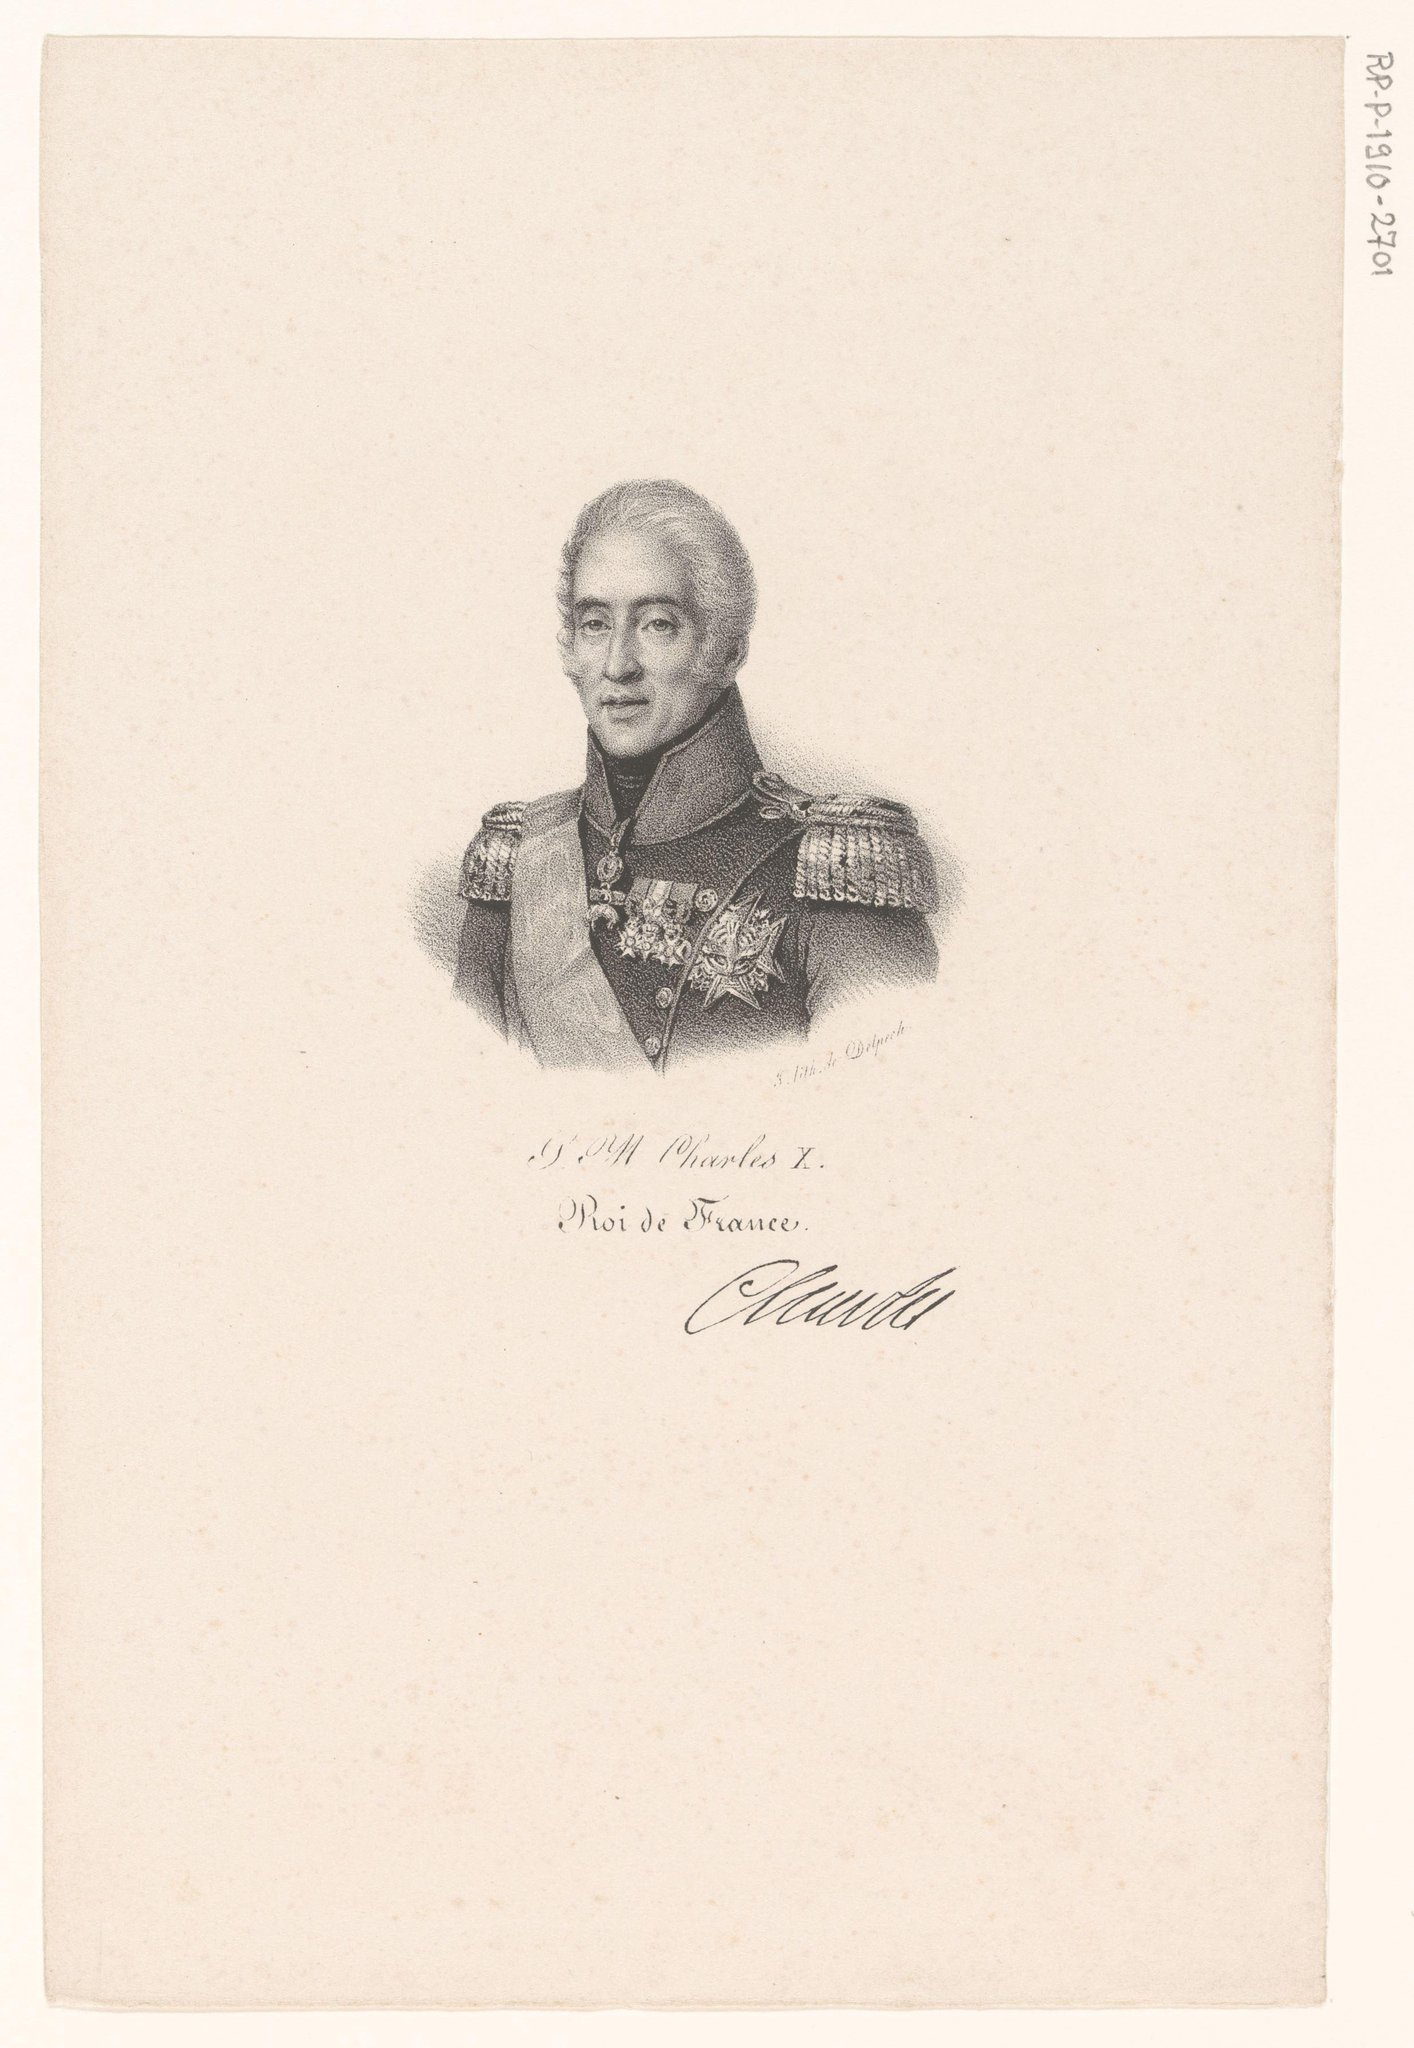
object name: print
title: Portret van Karel X van Frankrijk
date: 1818-1842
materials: paper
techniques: lithograph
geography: paris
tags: historical persons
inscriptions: collector's mark: Lugt 2228a